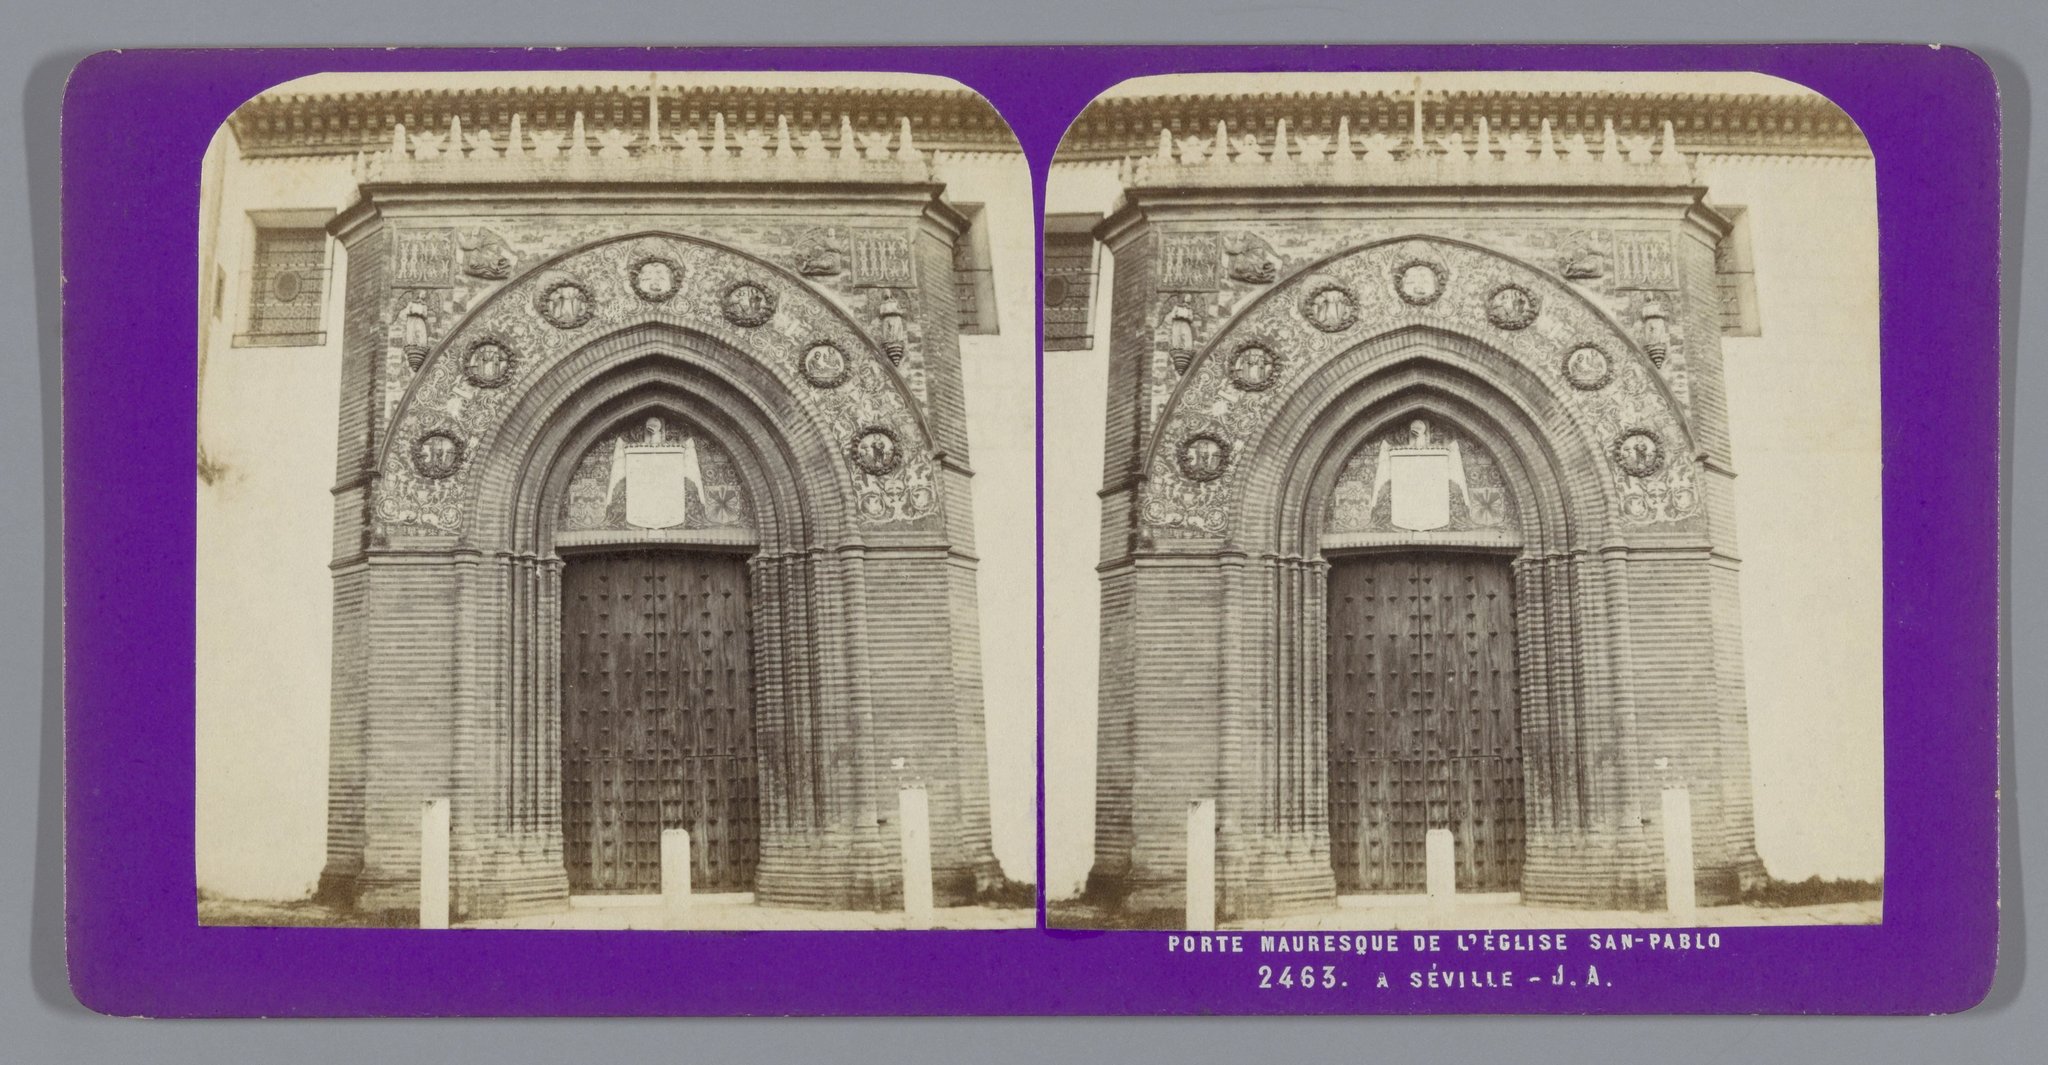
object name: stereograph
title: Poort van een kerk in Sevilla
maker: jean andrieu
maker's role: fotograaf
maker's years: 1816-1872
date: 1862-1876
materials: cardboard, photographic support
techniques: albumen print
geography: sevilla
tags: gate, entrance, sevilla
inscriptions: number: ‘2463.’